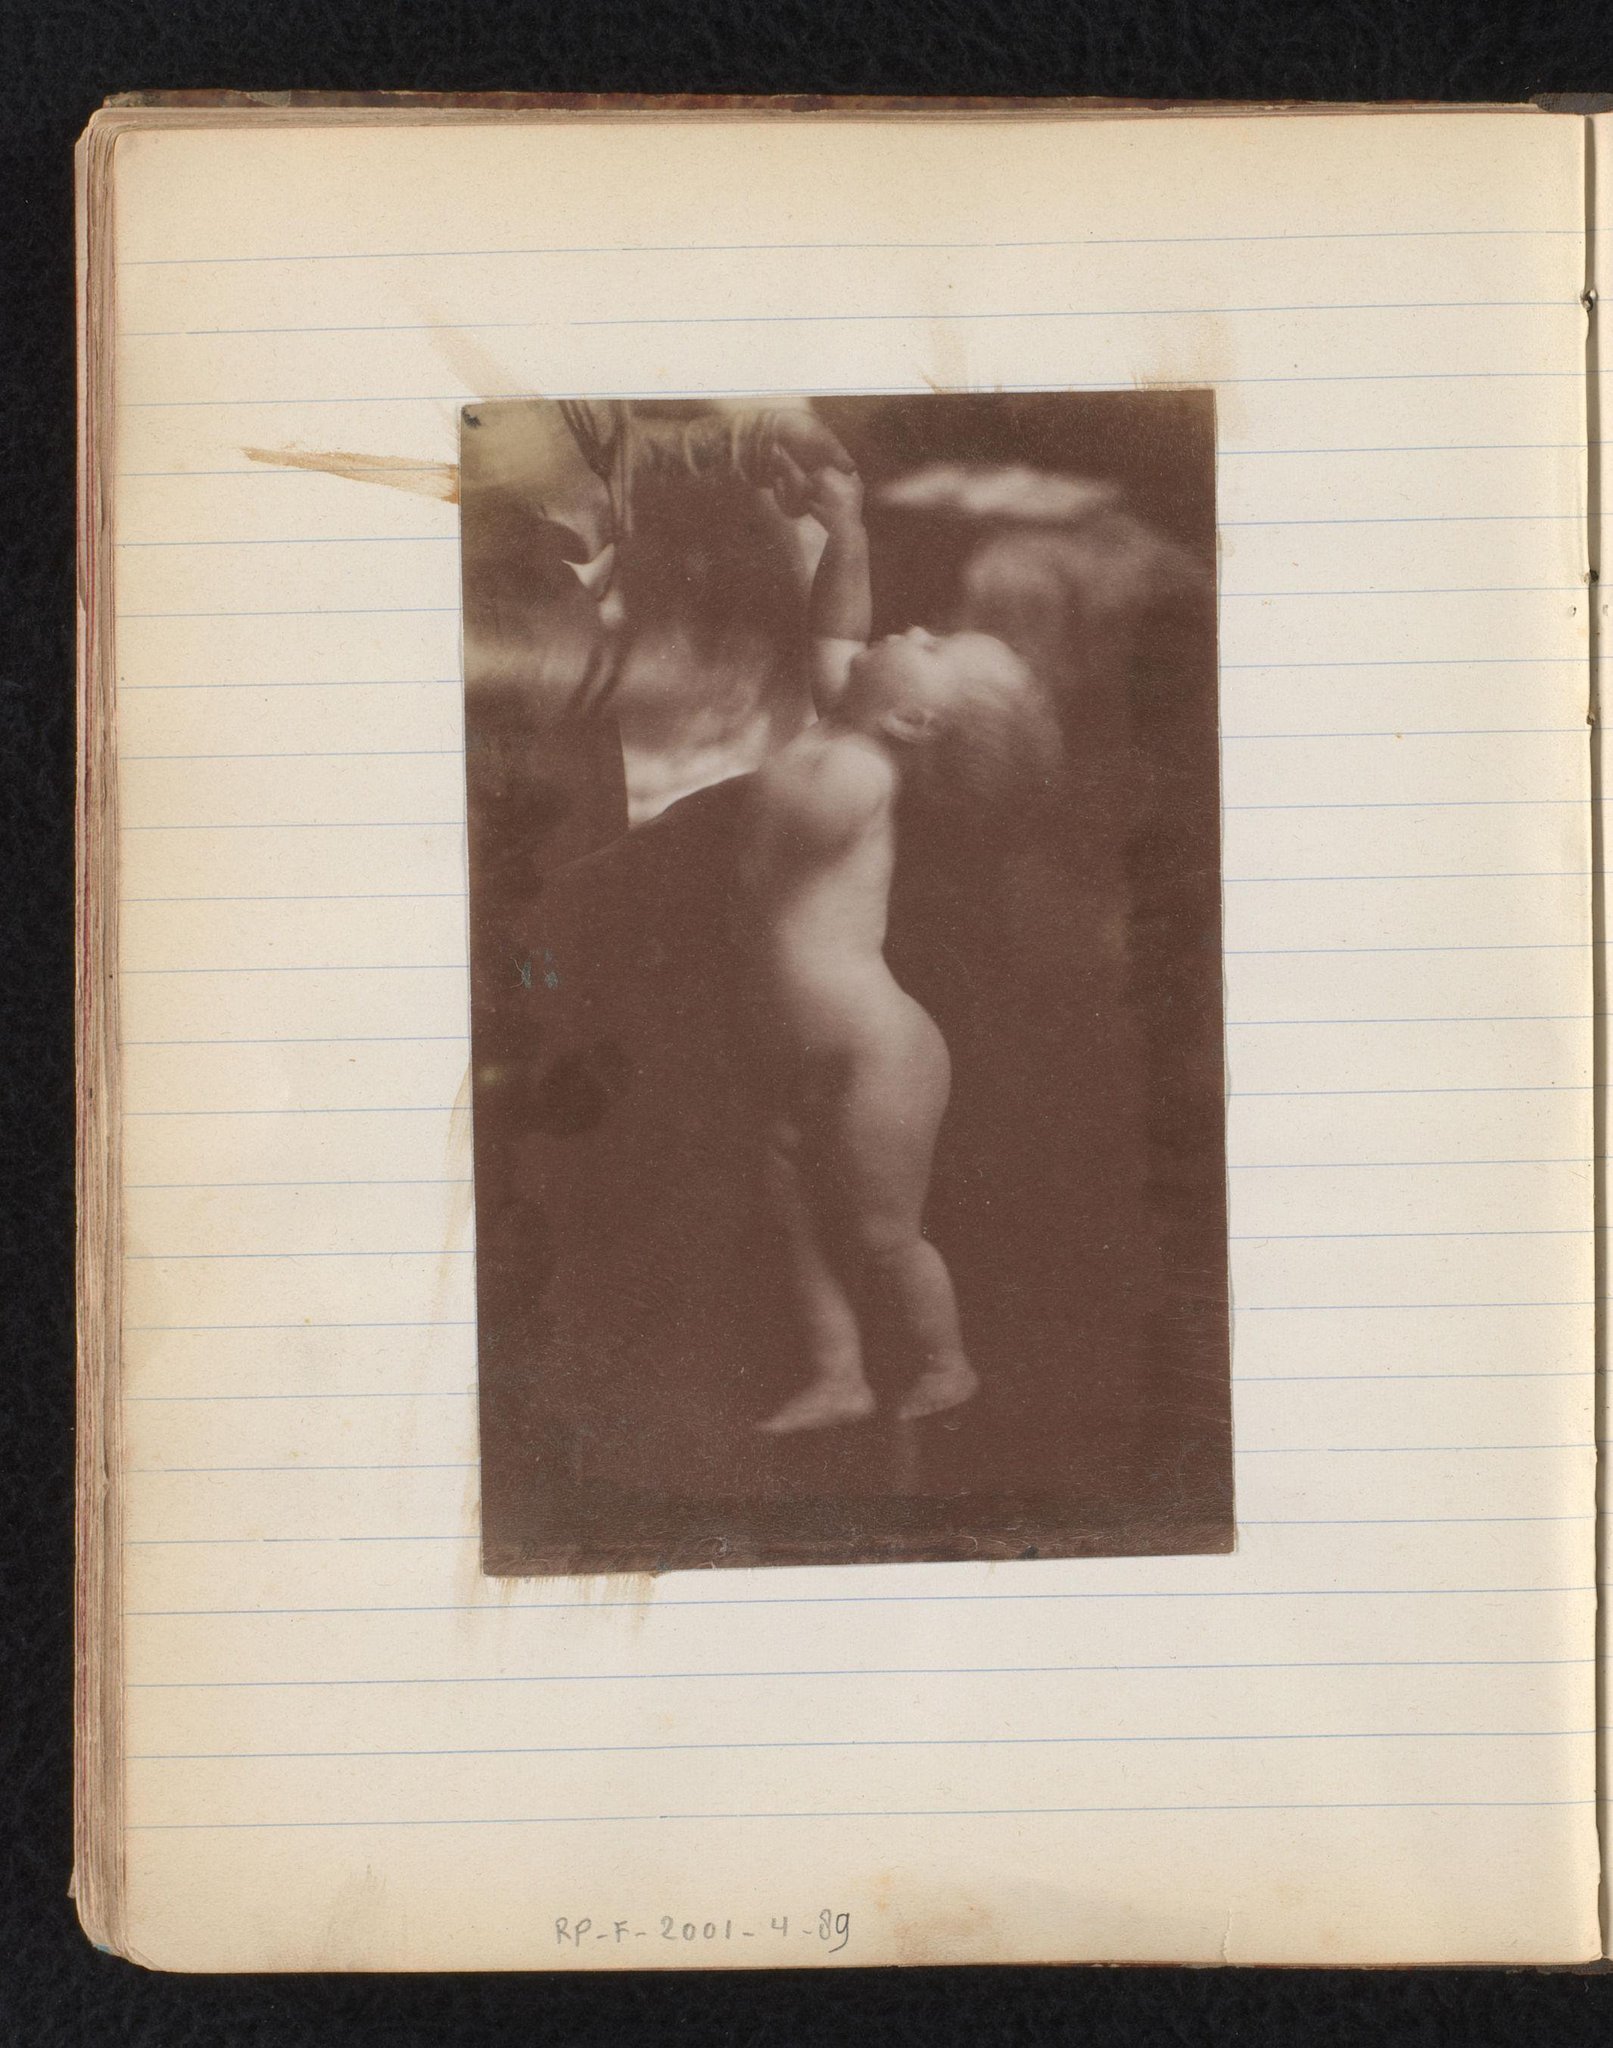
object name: photograph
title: Studie van een naakte peuter en vrouw, door Jacques de Lalaing, voorstudie voor Heilige Maagd met het kind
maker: jacques lalaing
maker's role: painter, sculptor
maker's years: 1858-1917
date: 1900-1914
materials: photographic support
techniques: albumen print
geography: brussels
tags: the (nude) human figure; 'corpo humano' (ripa), infant, baby, artist (in general) working from nude model